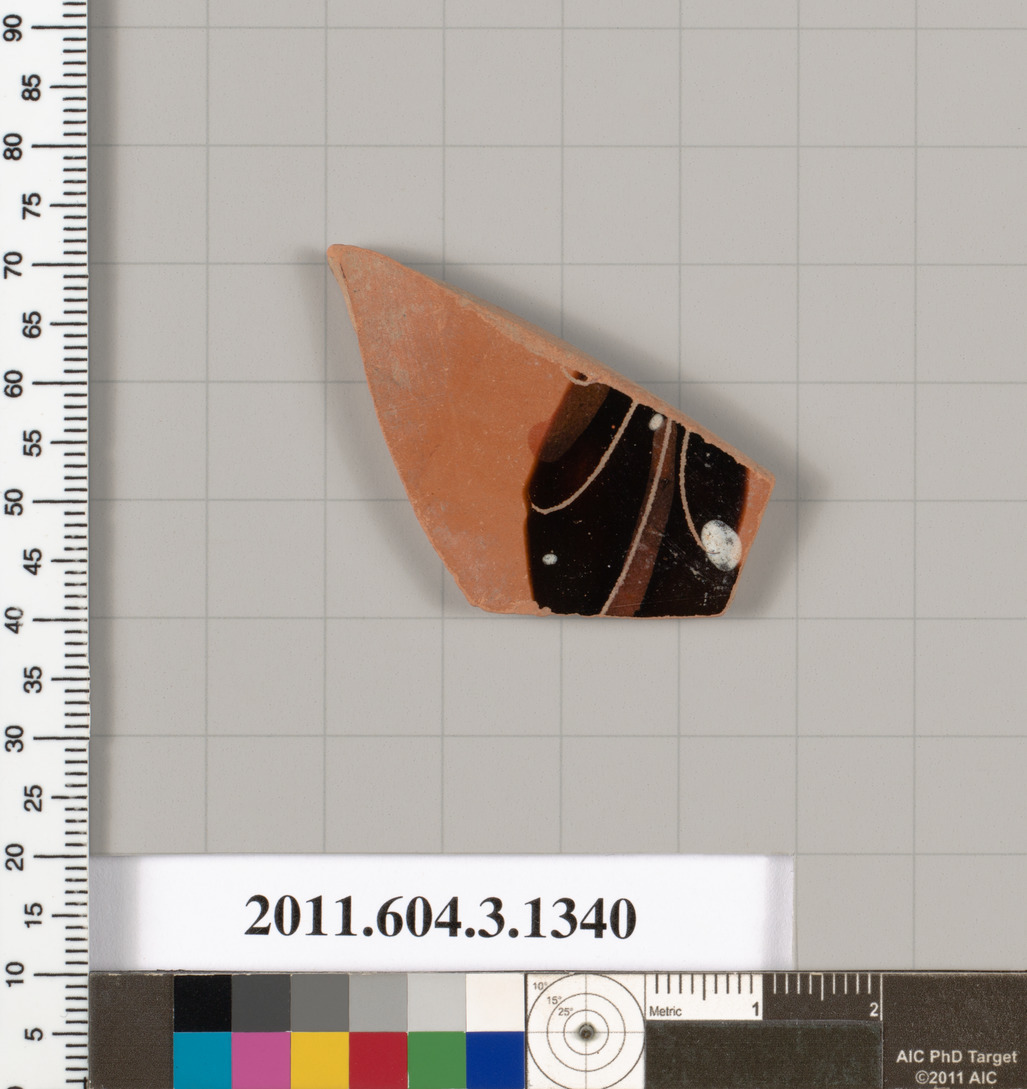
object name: skyphos fragment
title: Terracotta fragment of a skyphos (deep drinking cup)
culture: greek, attic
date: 500-468 BCE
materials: terracotta